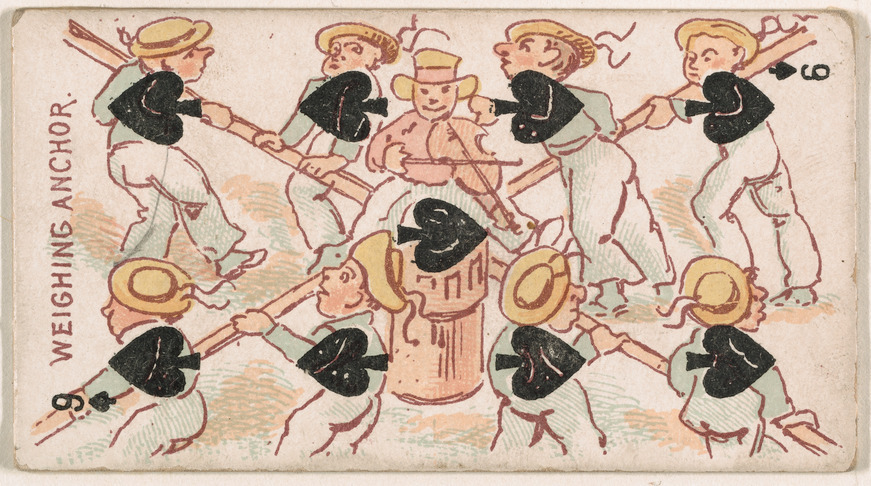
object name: print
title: Nine of Spades, Weighing Anchor, from Harlequin Cards, 2nd Series (N220) issued by Kinney Bros.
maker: kinney brothers tobacco company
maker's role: publisher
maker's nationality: american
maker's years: 1869-2011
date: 1889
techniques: color lithograph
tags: playing cards